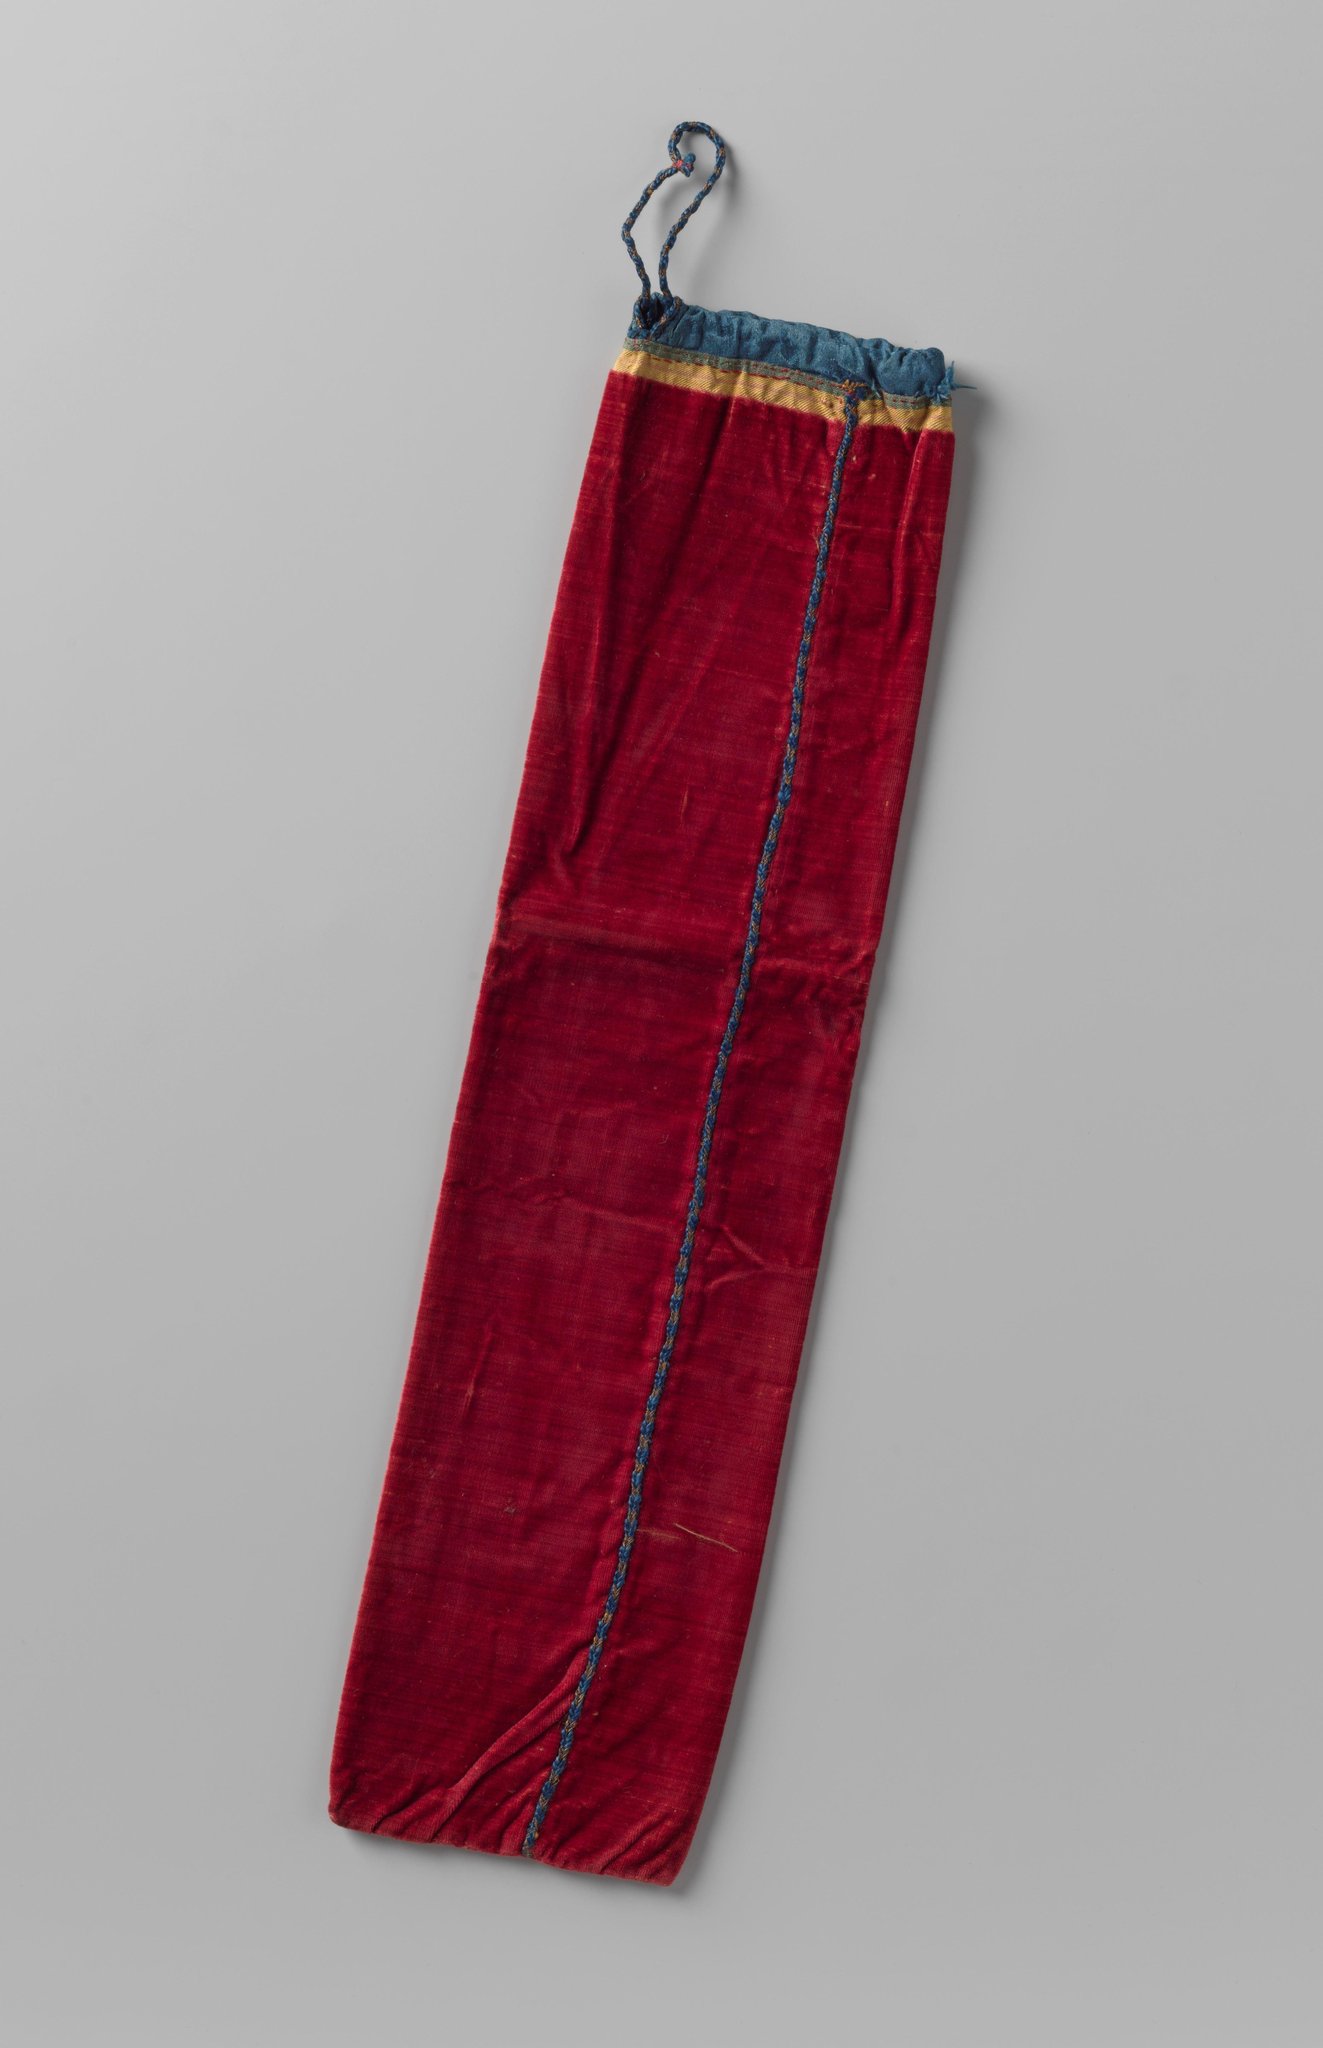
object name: envelope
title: Envelop behoort bij een brief van de keizer van Marokko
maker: Anonymous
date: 1686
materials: velvet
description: Diplomatic stationary, second half 17th century. Special envelopes were used for diplomatic correspondence. The velvet envelope contained a letter (dated 20 September 1686) from the emperor of Morocco to the States General concerning deliveries of weapons from the Republic. The silk envelope contained a letter sent in 1668 by the Dutch representative in Constantinople (Istanbul), Justinus Coljer, to the States General. The painting above shows a Russian diplomatic delegation at the Binnenhof in The Hague bearing a sealed envelope. On loan from Algemeen Rijksarchief, Den Haag.